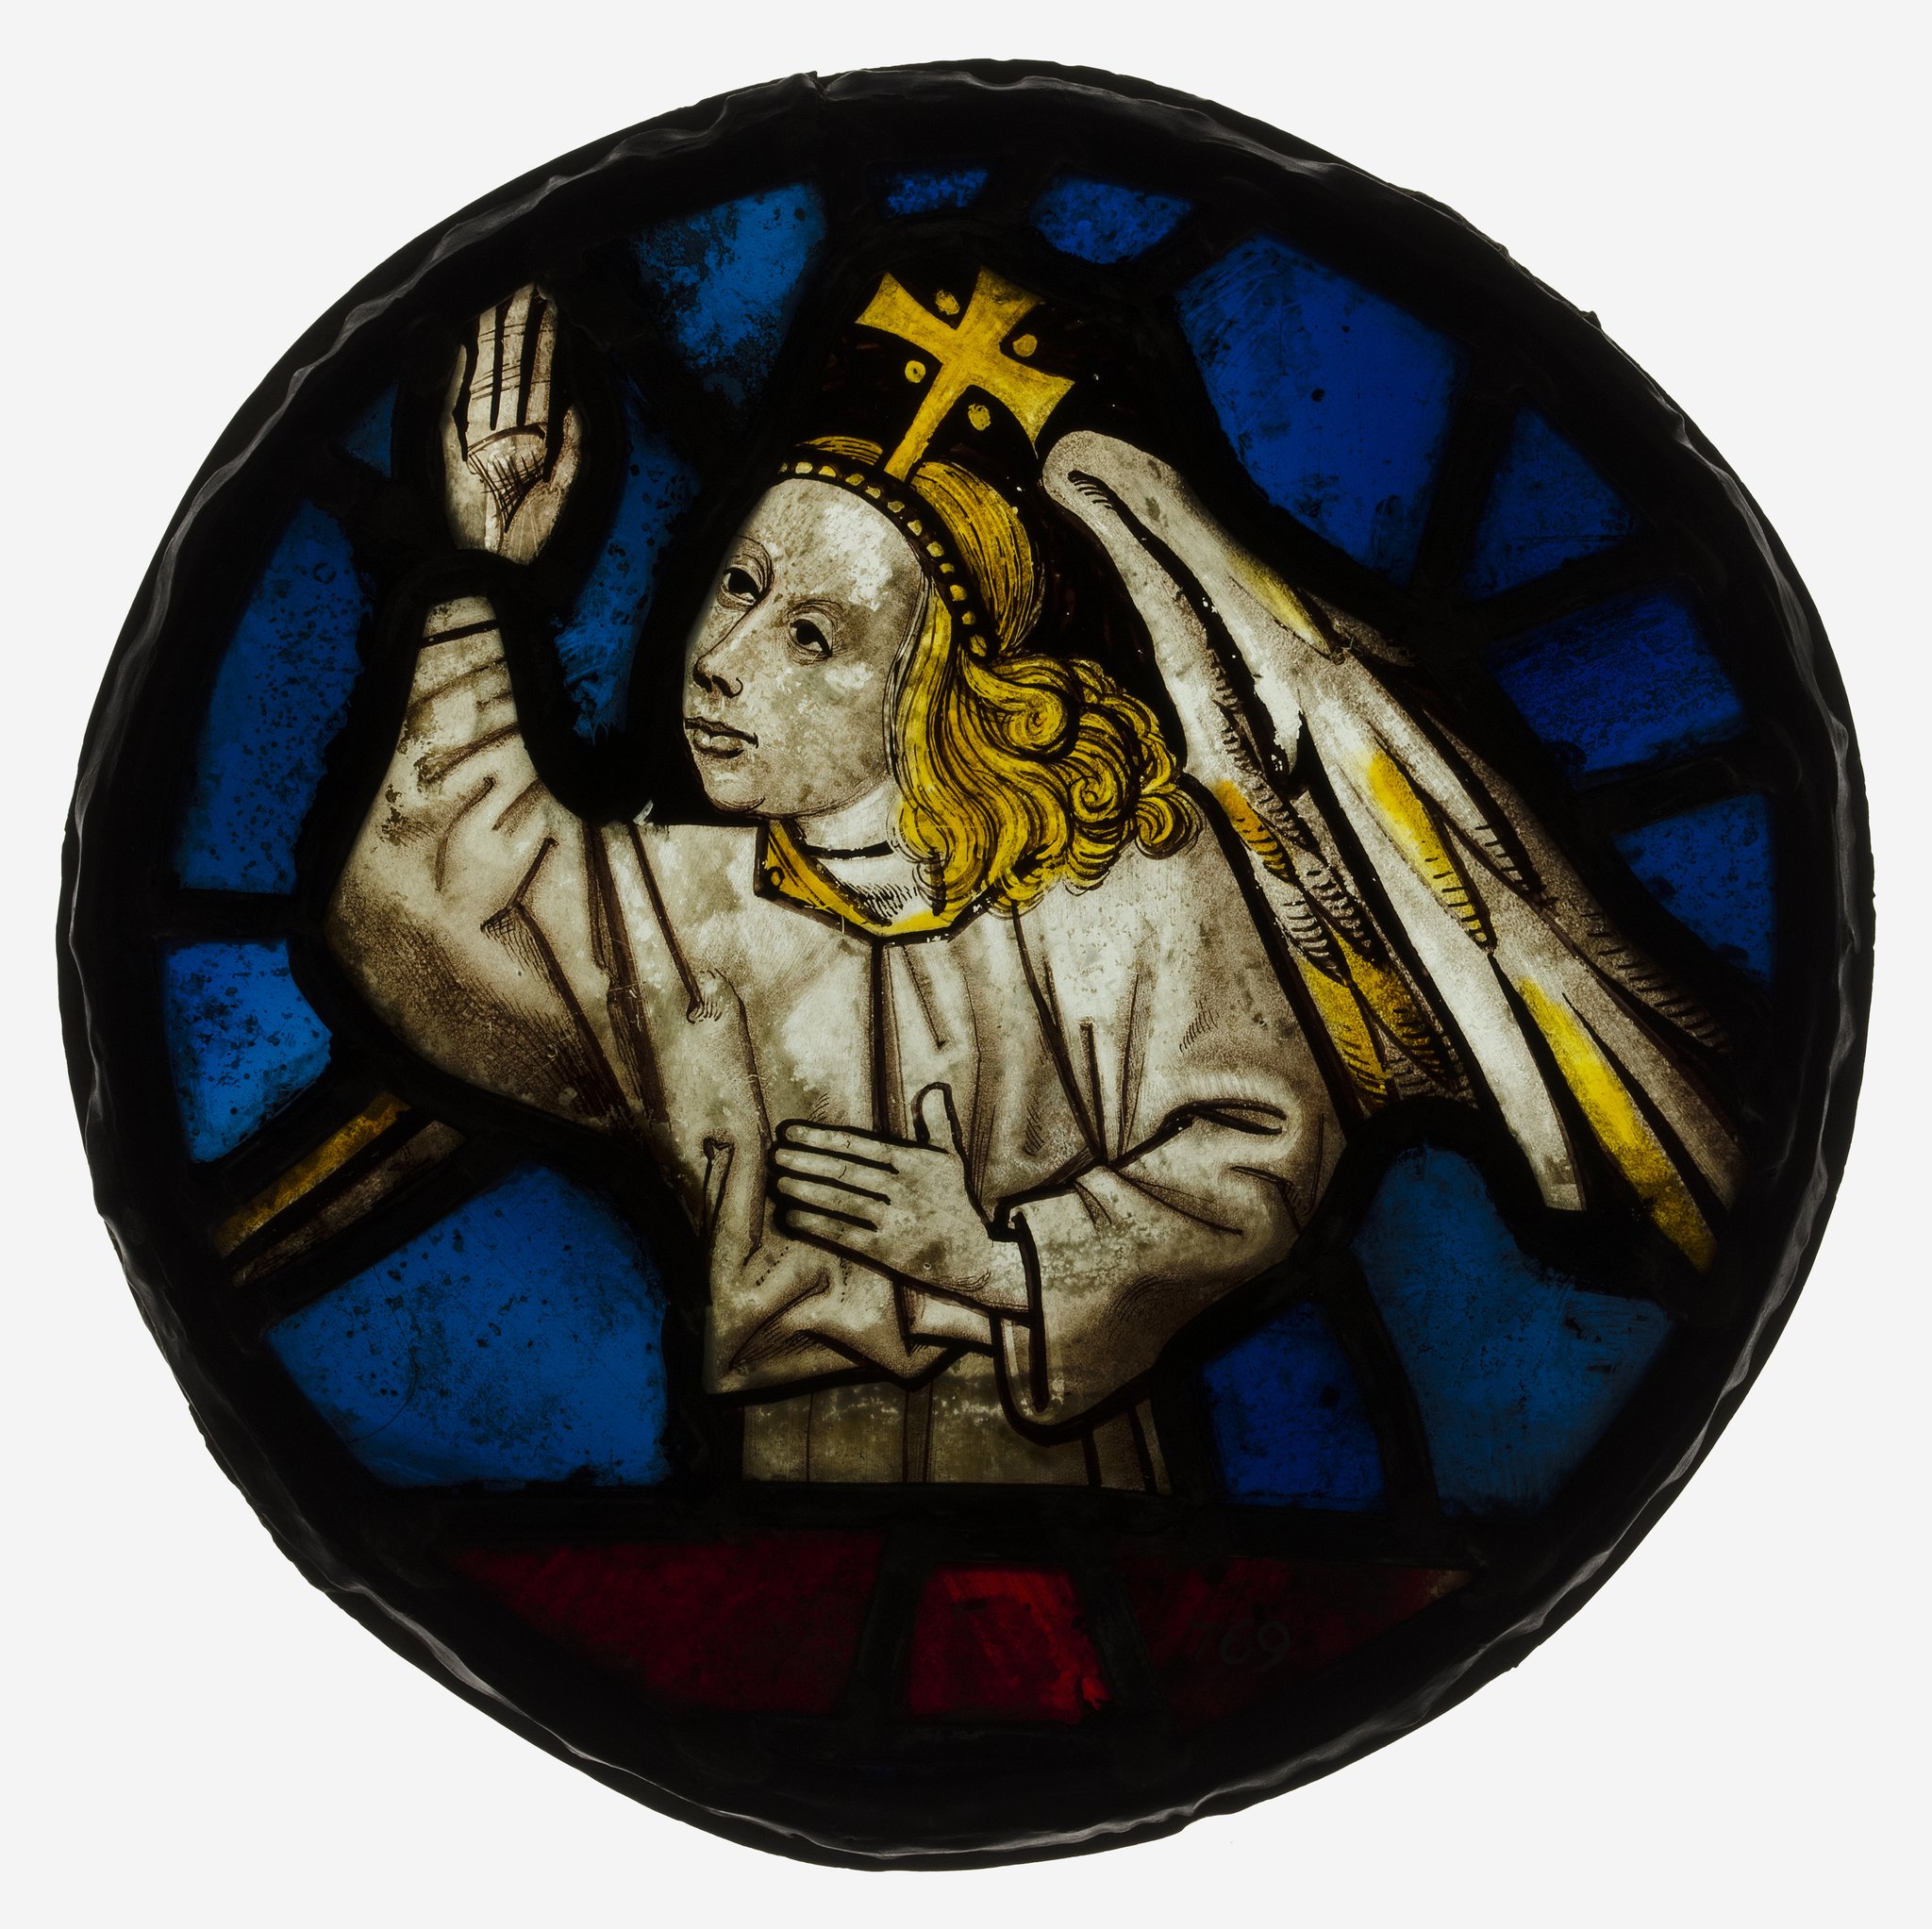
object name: roundel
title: Angel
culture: british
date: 1434-1466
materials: glass, metal, paint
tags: cross